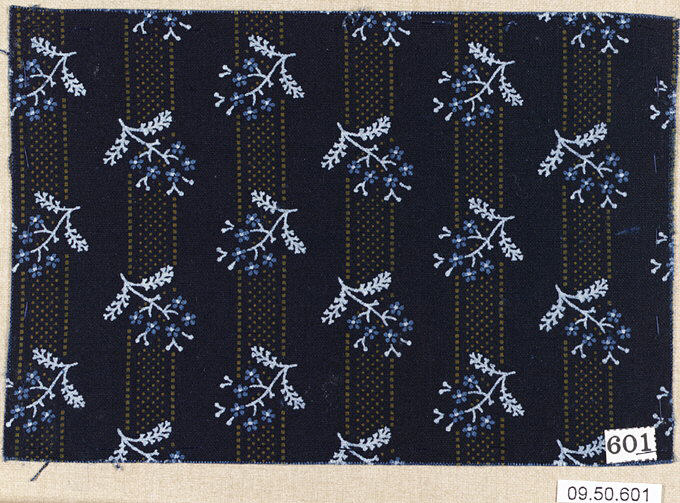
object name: piece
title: Pieces (5)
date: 1801-1900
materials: cotton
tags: flowers,leaves